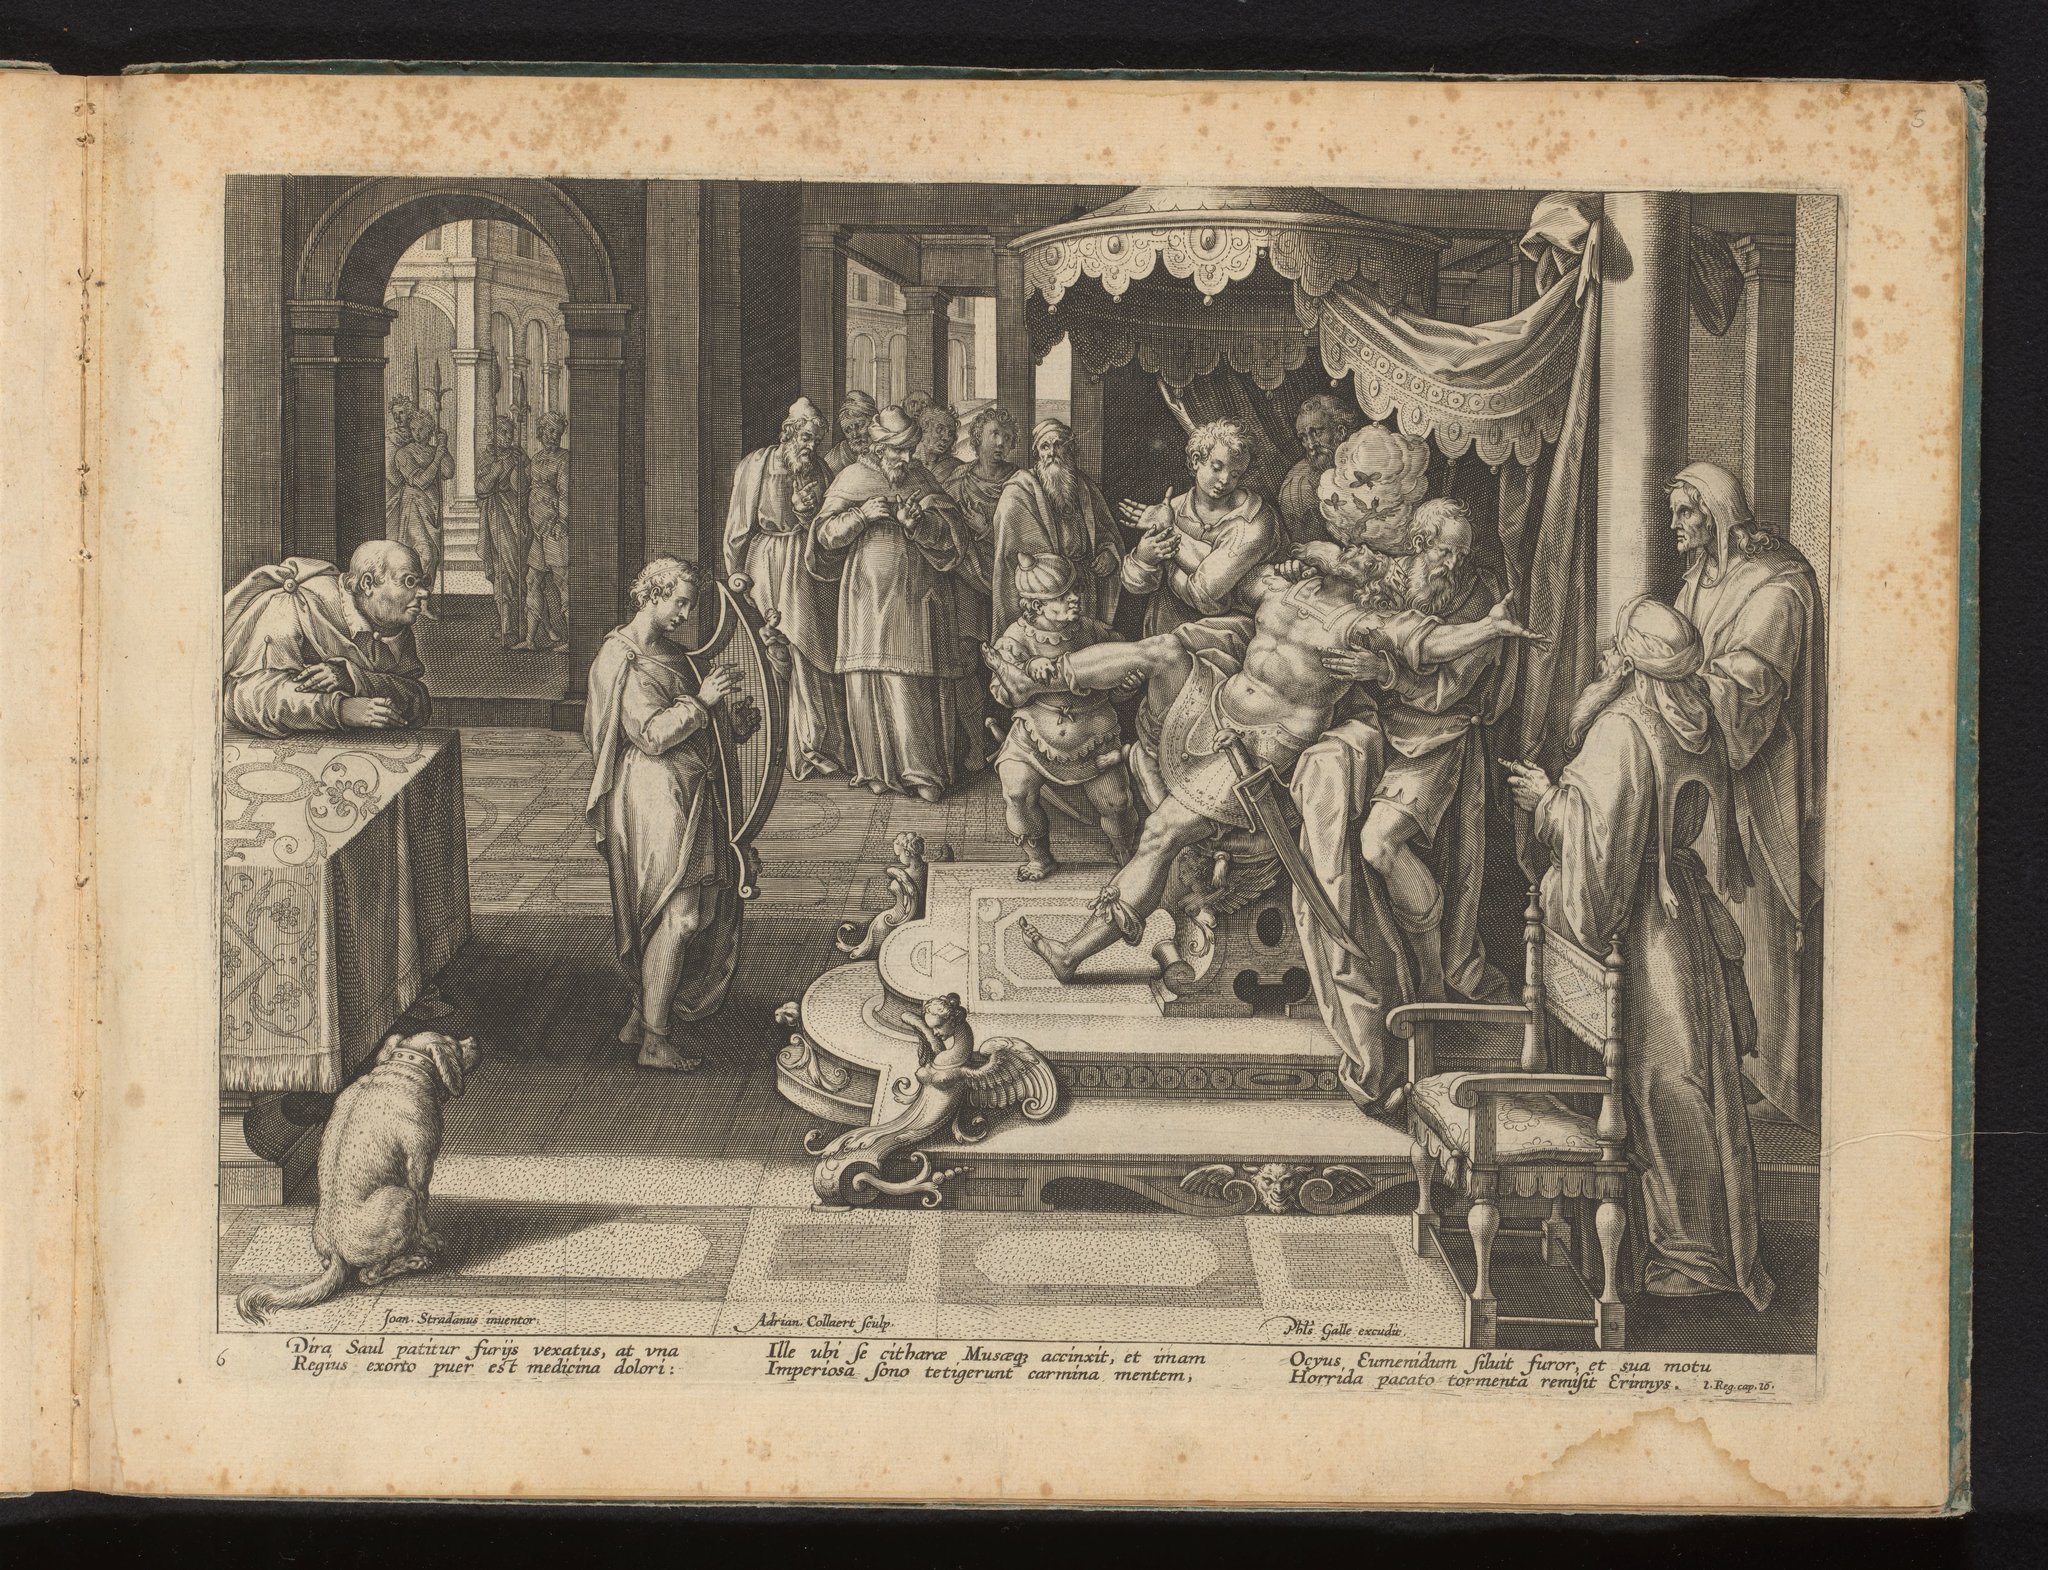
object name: album leaf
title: David speelt op zijn harp voor koning Saul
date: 1587-1592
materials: paper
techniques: engraving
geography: antwerp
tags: eyeglasses, spectacles, david as harpist at saul's court (1 samuel 16:14-23), david playing his harp before saul, harp, madness, saul troubled by an evil spirit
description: De jonge David speelt op zijn harp voor koning Saul. Het harpspel verjaagt de kwade geest die Saul kwelt. Hij zit in waanzinnige toestand op zijn troon en wordt vastgehouden door drie mannen. Links bij een tafel kijken een man met knijpbril en een hond aandachtig toe. De prent heeft een Latijns onderschrift met verzen. Rechtsonder de verwijzing naar bijbelboek 1 Samuël 16.